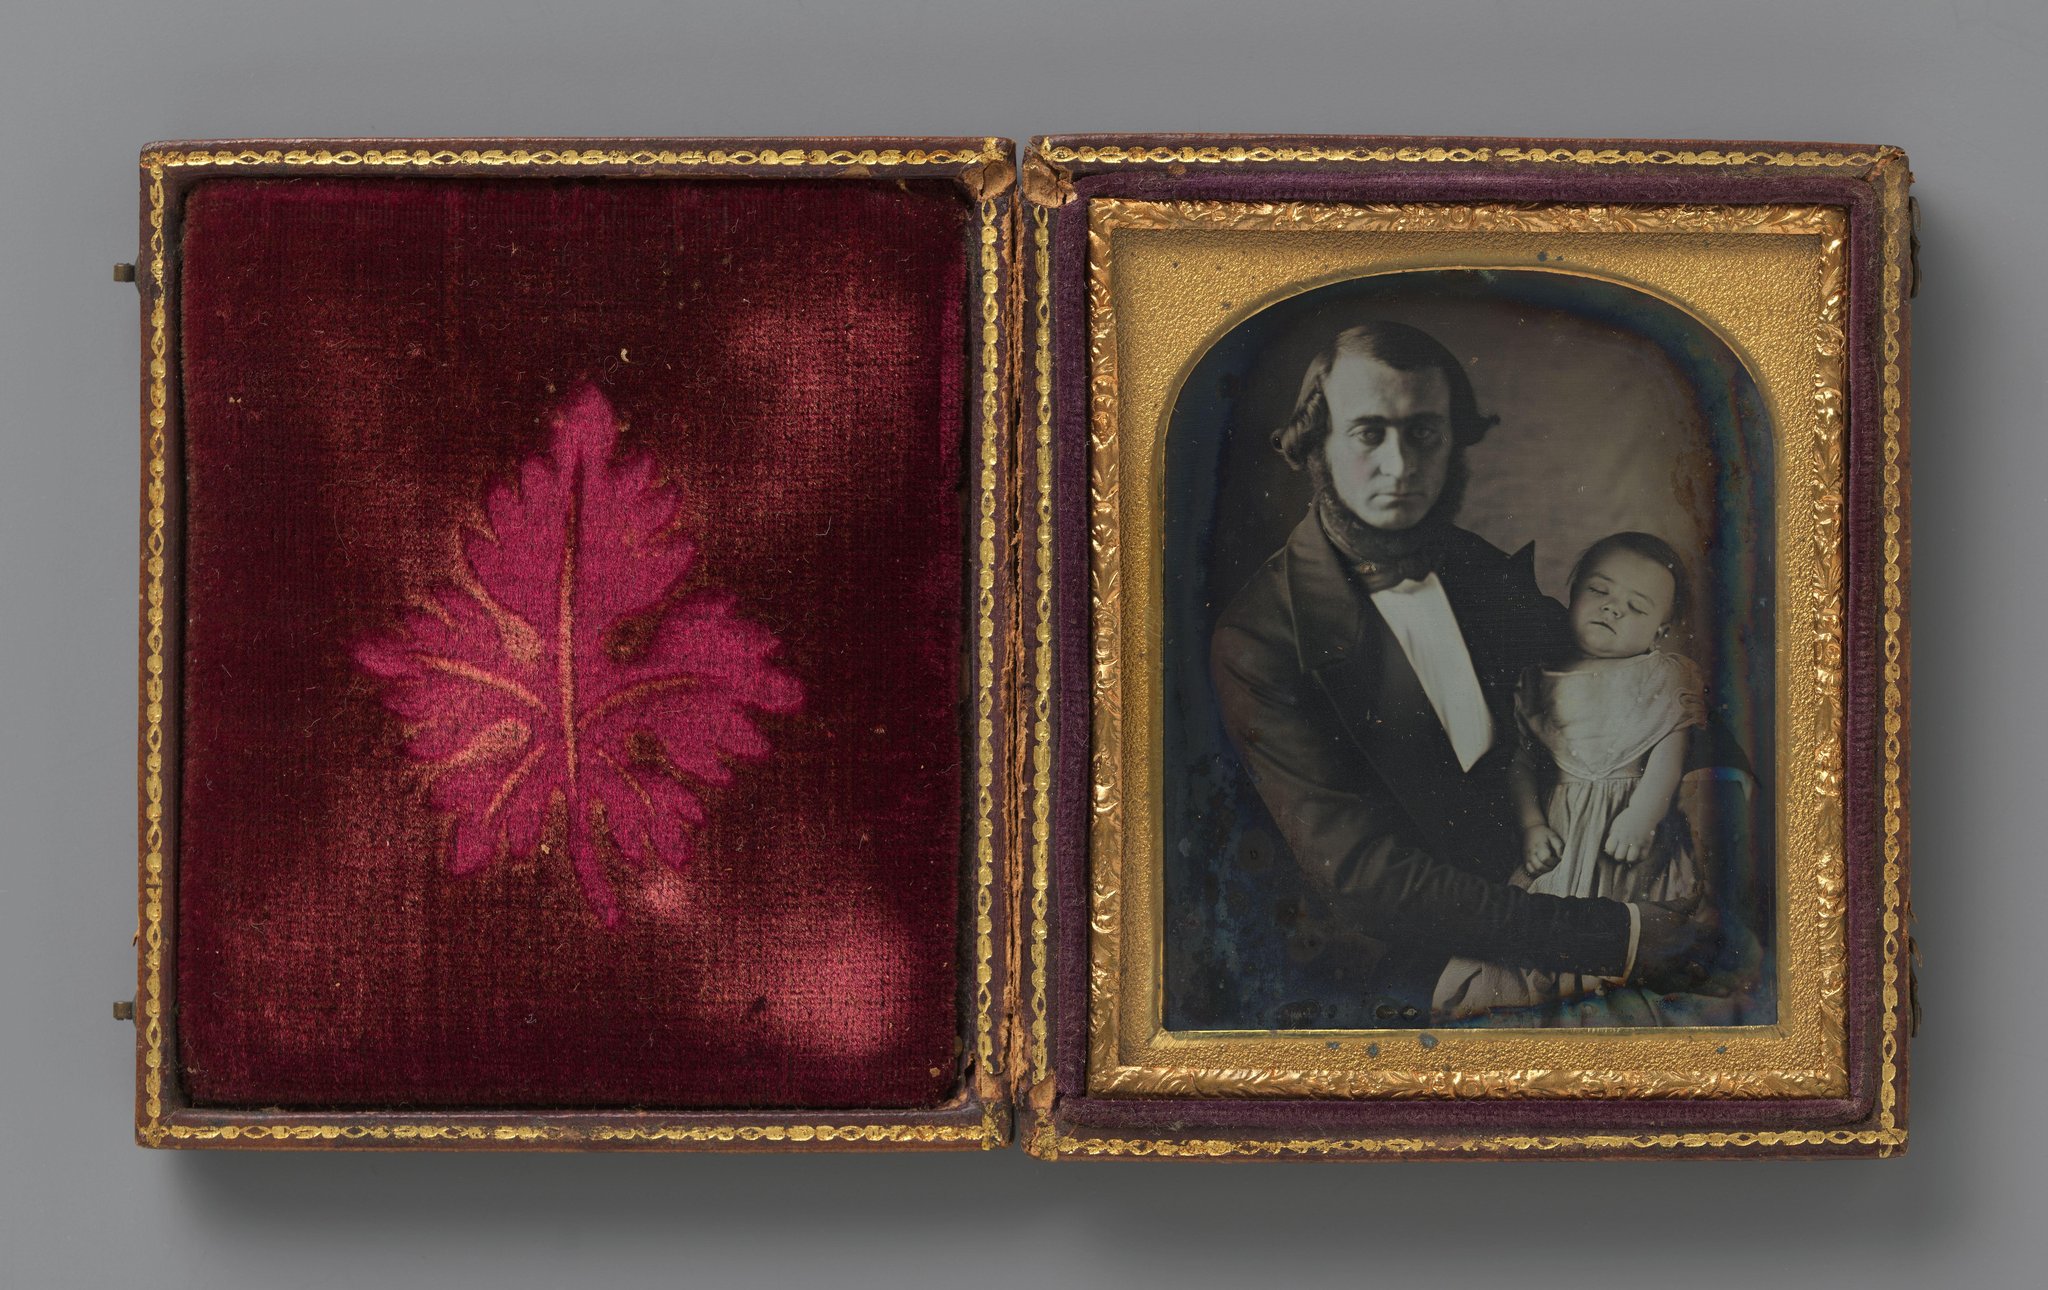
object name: photograph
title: Portret van een man met (waarschijnlijk) een overleden kind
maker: Anonymous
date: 1850-1860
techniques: daguerreotype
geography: united states